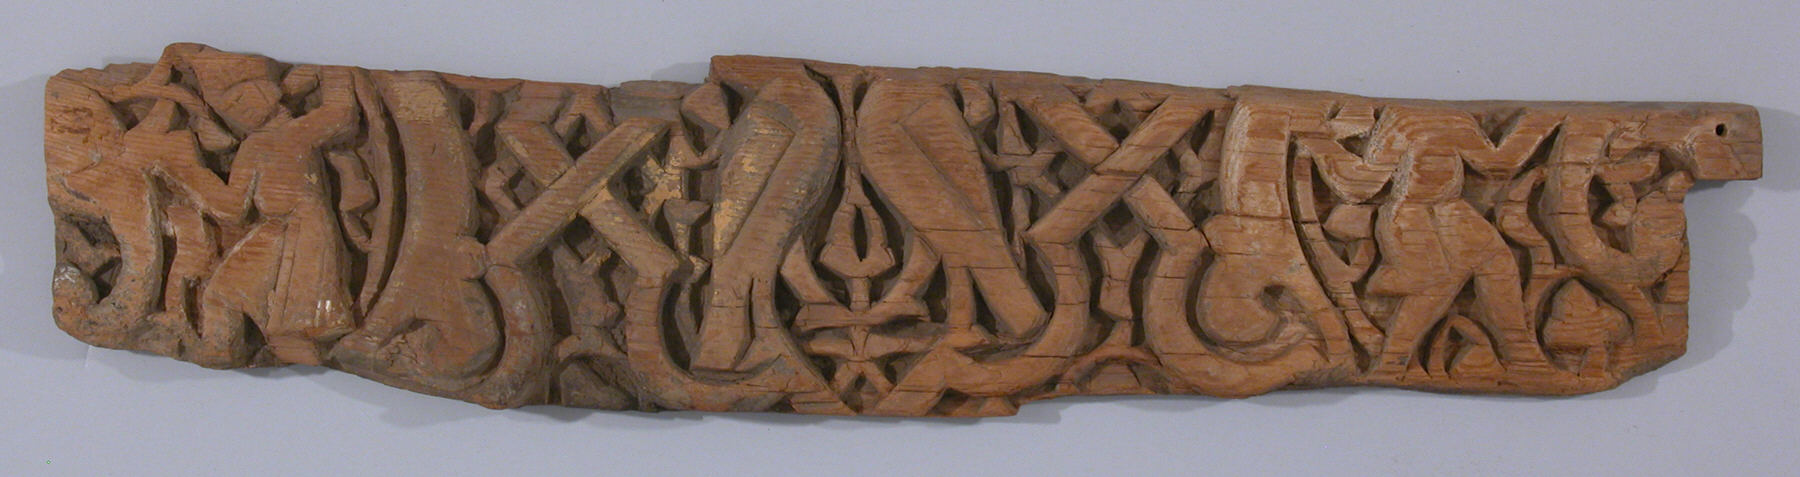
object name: panel fragment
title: Fragment of a Panel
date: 1034-1066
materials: wood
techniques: carving, painting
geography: egypt